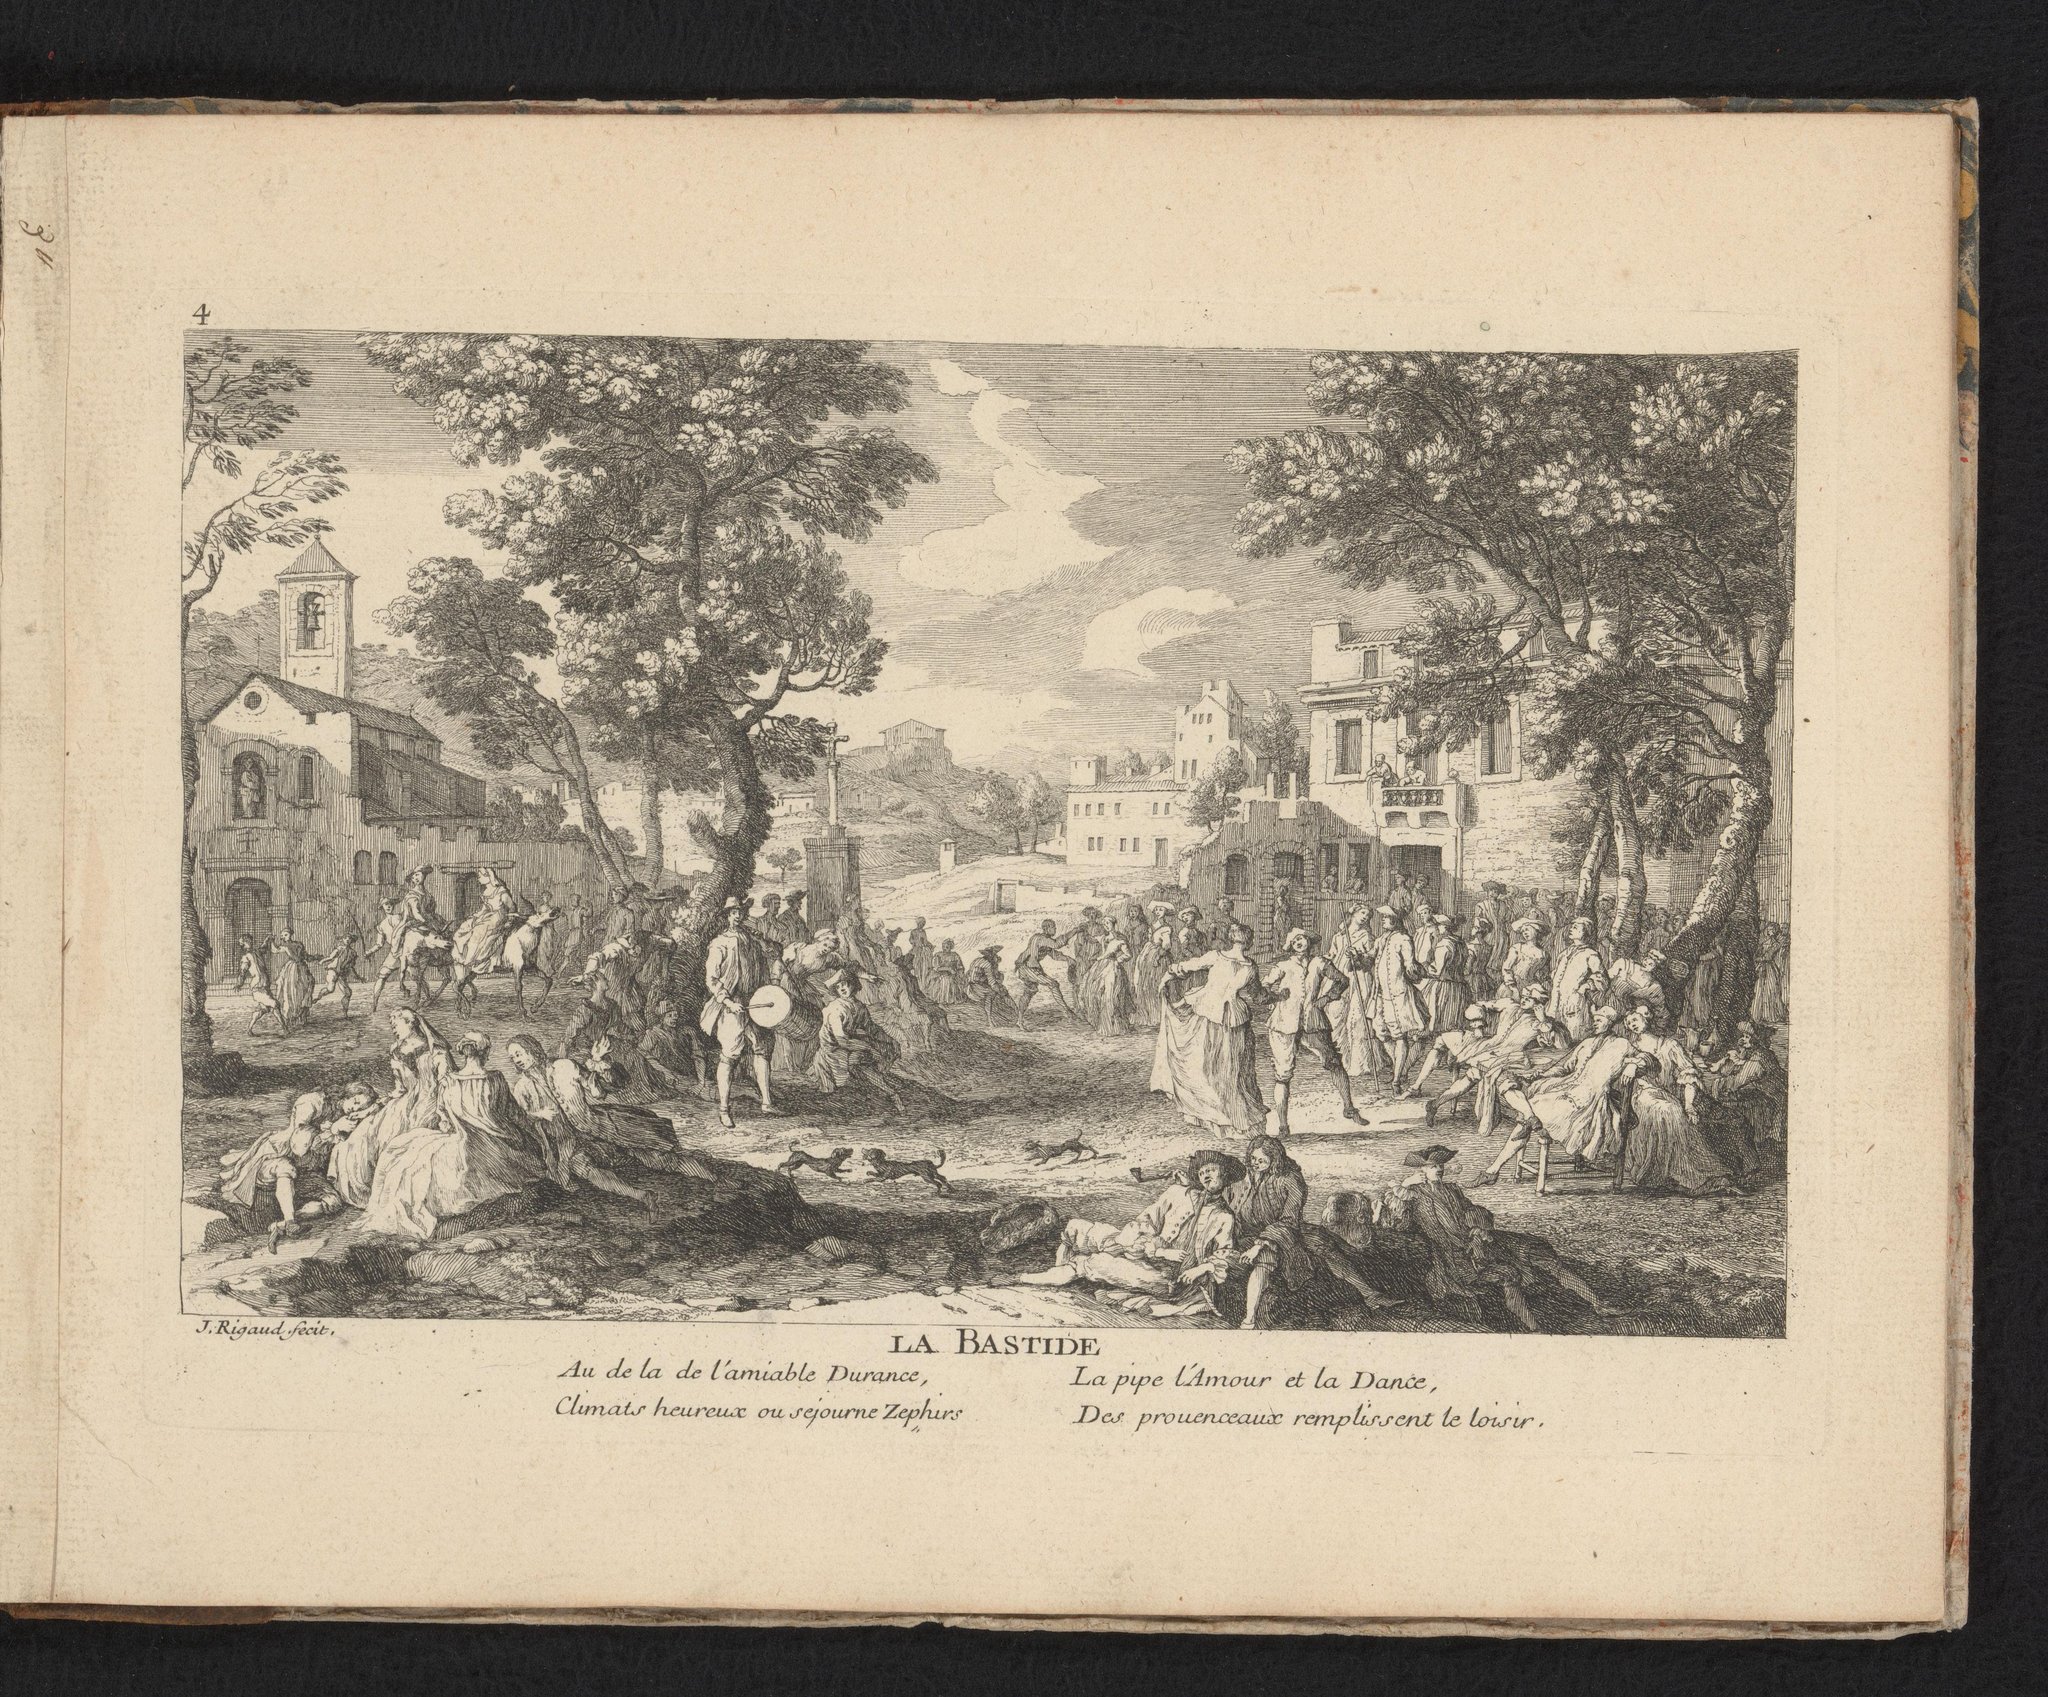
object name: album leaf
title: Volksvermaak in de Provence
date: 1700-1725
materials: paper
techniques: etching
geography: paris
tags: folk dancing (men and women together), village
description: Deze prent maakt deel uit van een album.